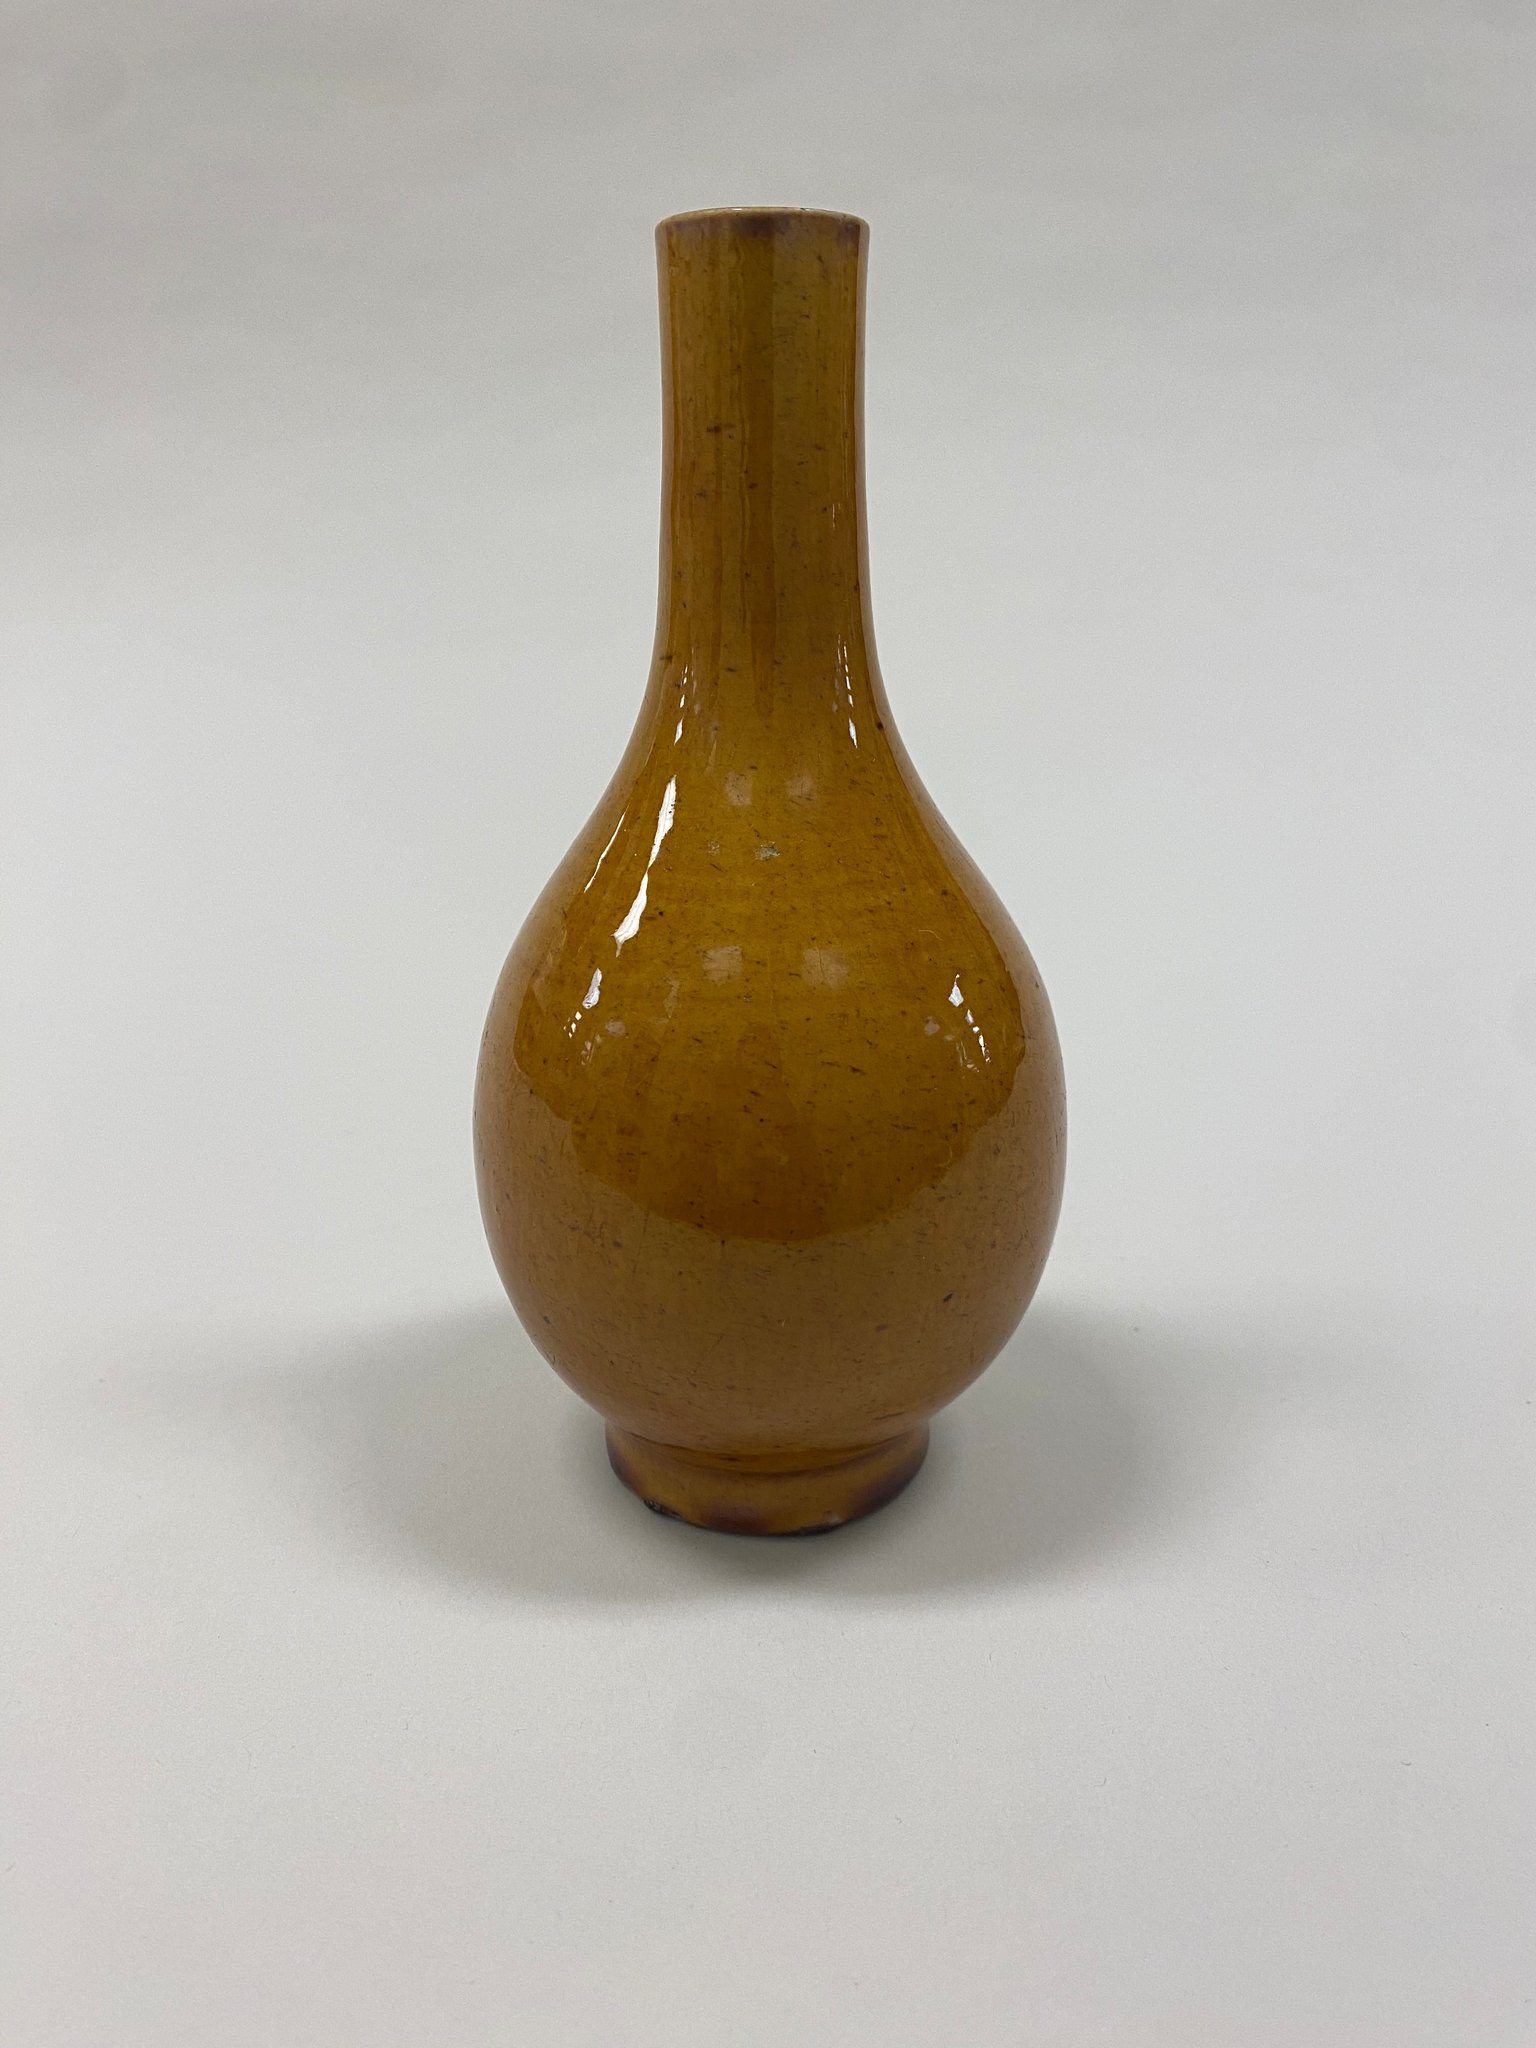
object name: vase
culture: chinese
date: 1701-1800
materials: glaze, porcelain